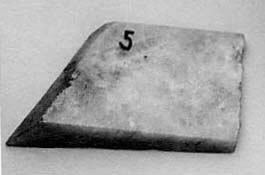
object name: fragment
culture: burmese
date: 1902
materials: jade